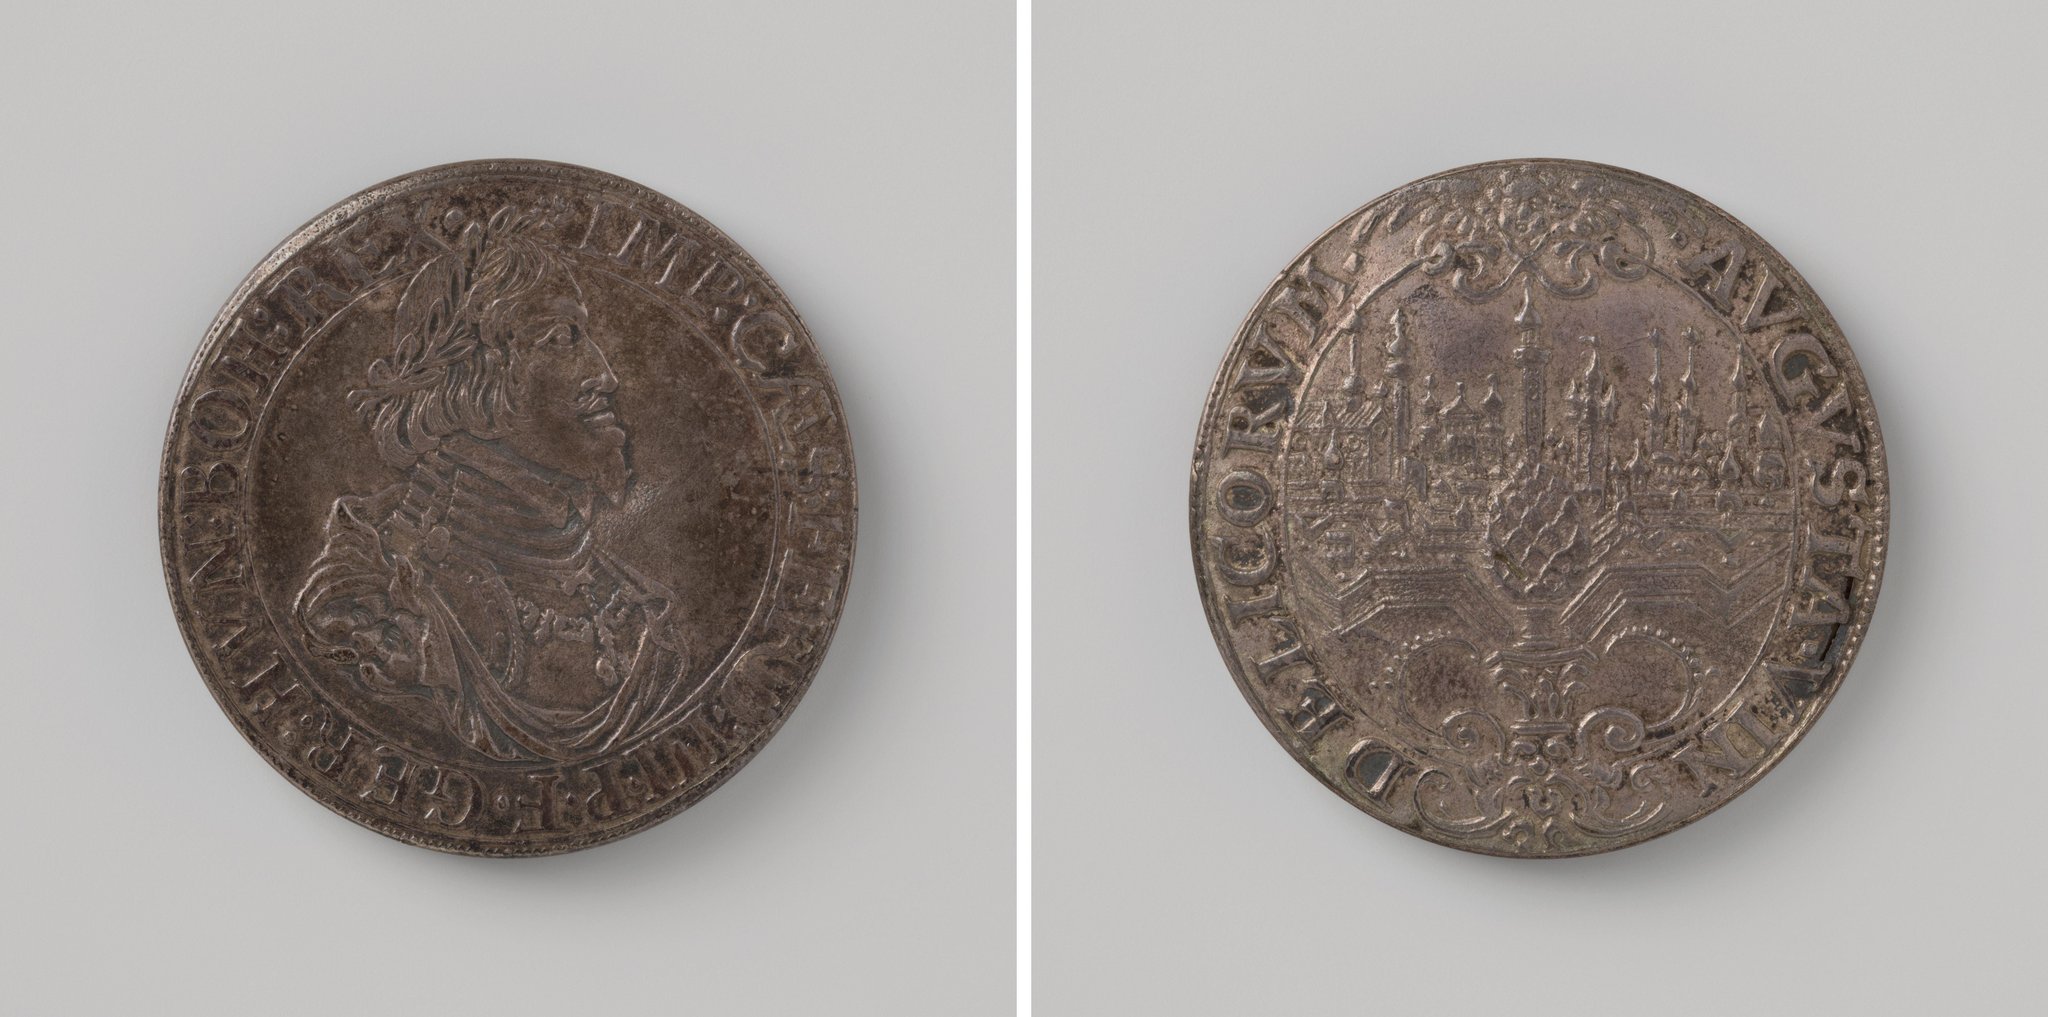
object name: taler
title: Rijksstad Augsburg, keizer Ferdinand III, schroefthaler, 1639-1645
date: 1639-1645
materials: silver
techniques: striking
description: Zilveren bewerkte munt, muntplaatje uitgehold, van dikkere rand en van schroefdraad voorzien. Voorzijde: gelauwerd borstbeeld van de keizer naar rechts. Keerzijde: pijnappel op zuil, waarachter gezicht op de stad. Jaartal verwijderd. Gladde rand.